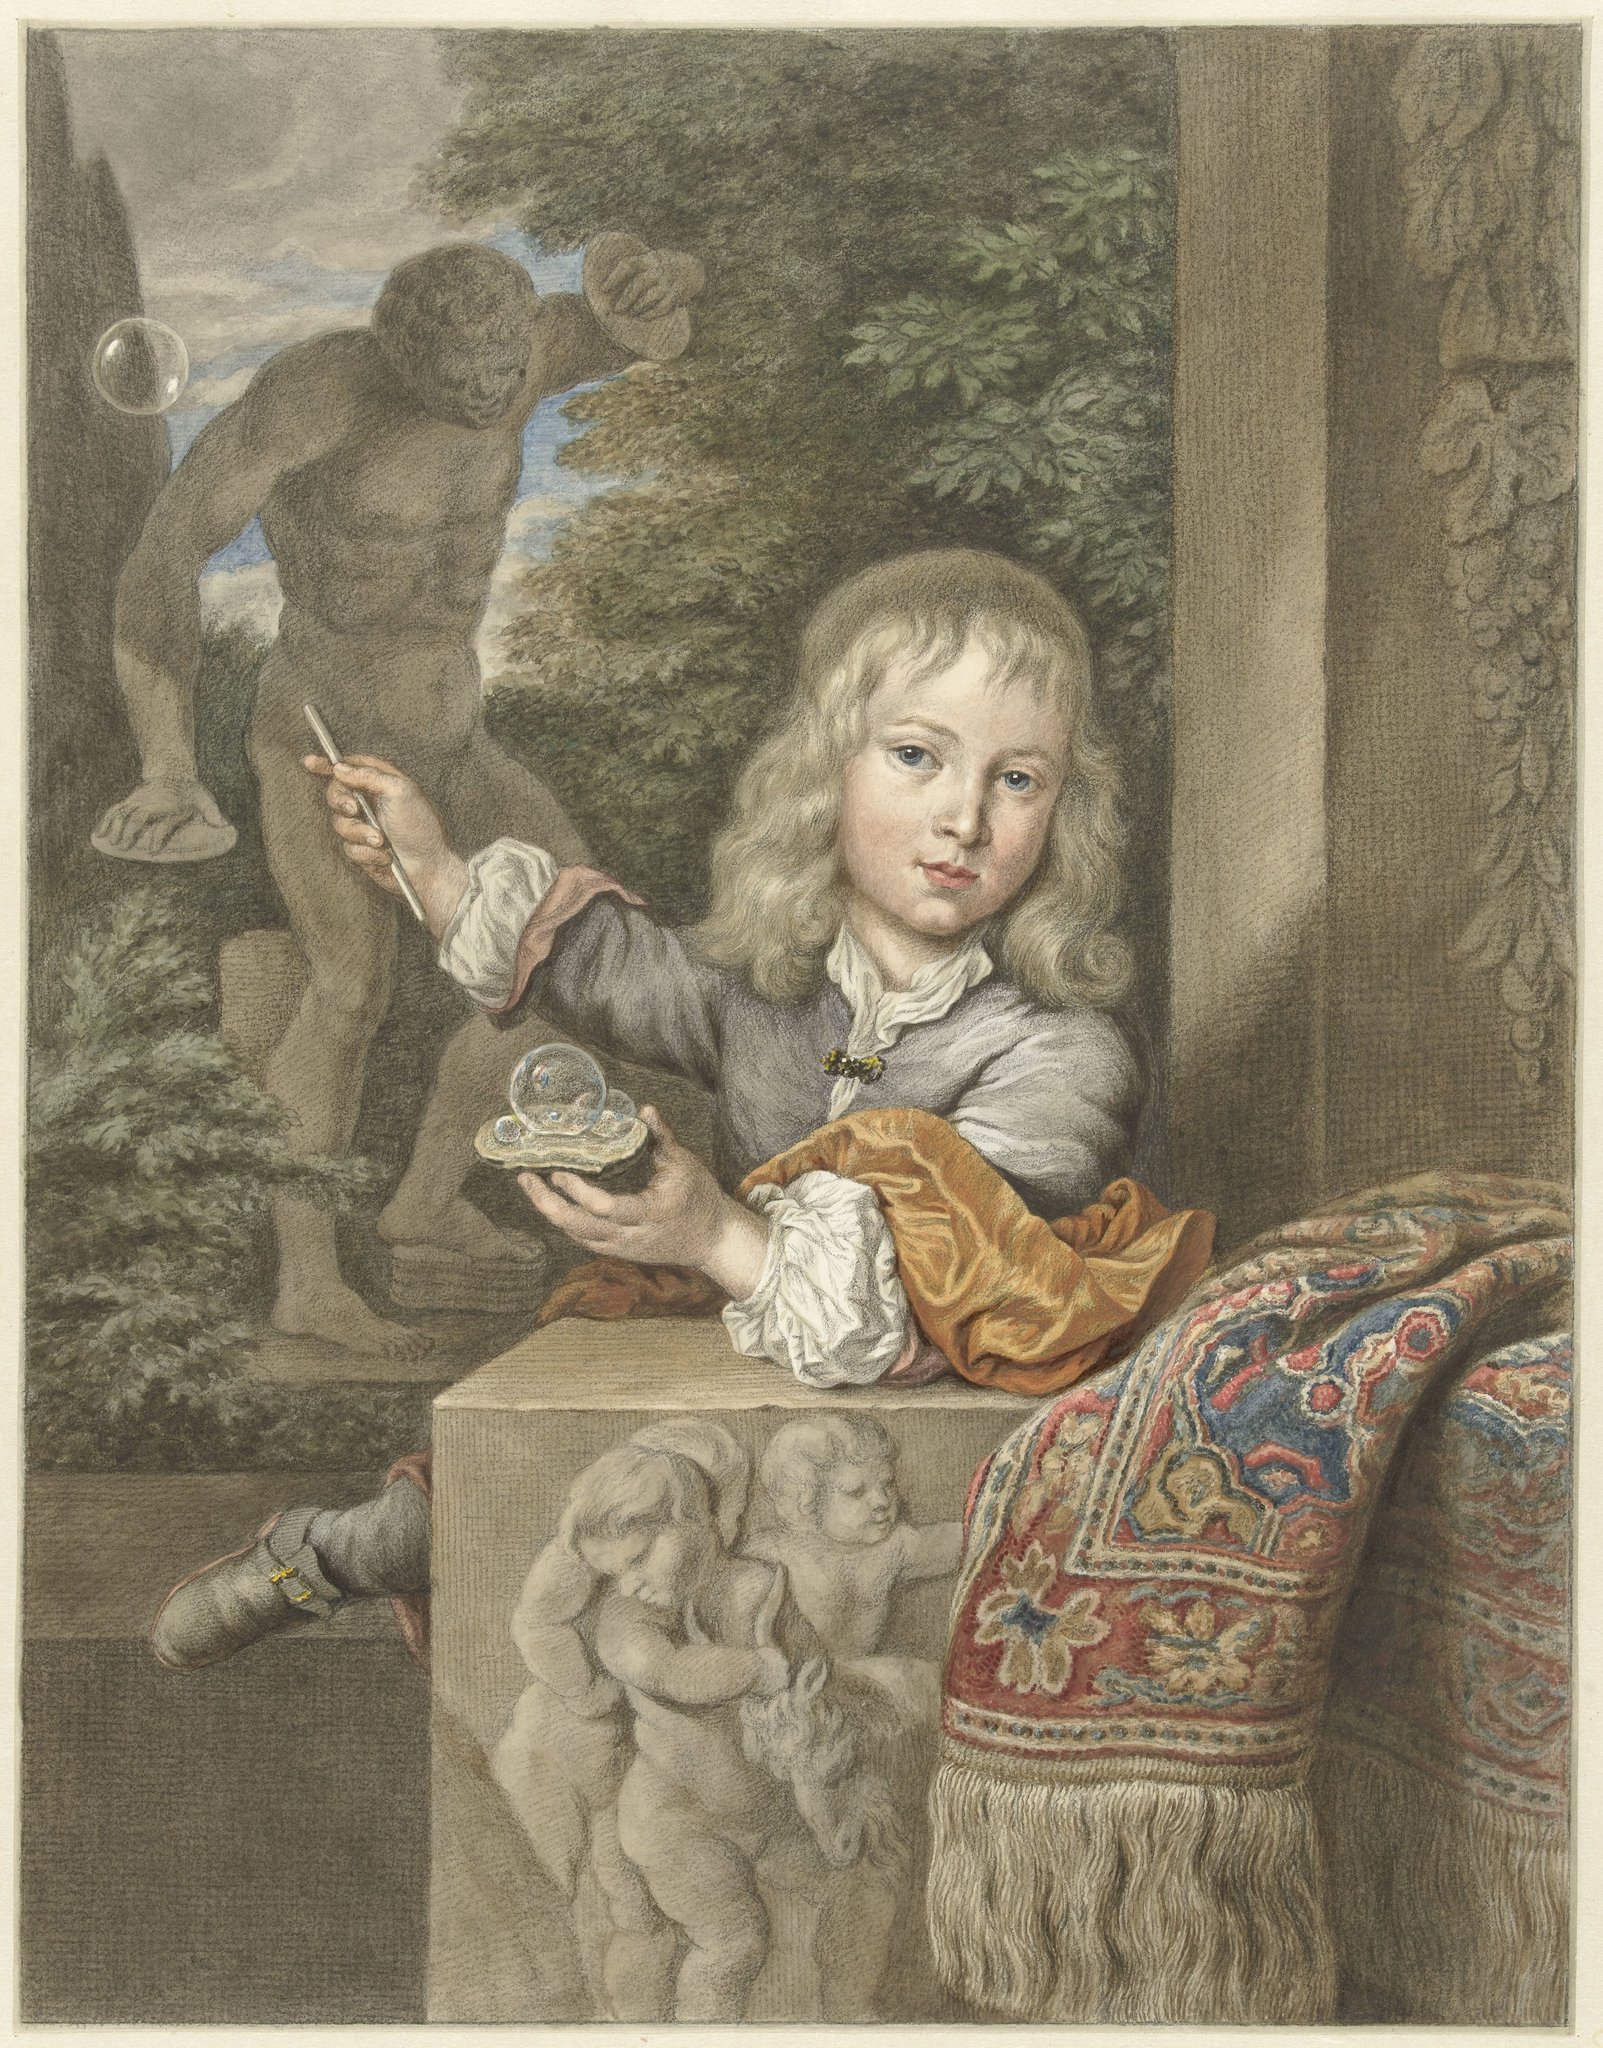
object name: watercolor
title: Bellenblazende jongen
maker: abraham delfos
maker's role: draughtsman, painter, print maker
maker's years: 1731-1820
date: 1741-1820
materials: chalk, paper, watercolor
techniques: brush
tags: (children or putti) blowing bubbles, 'homo bulla' ~ scene symbolizing 'vanitas'